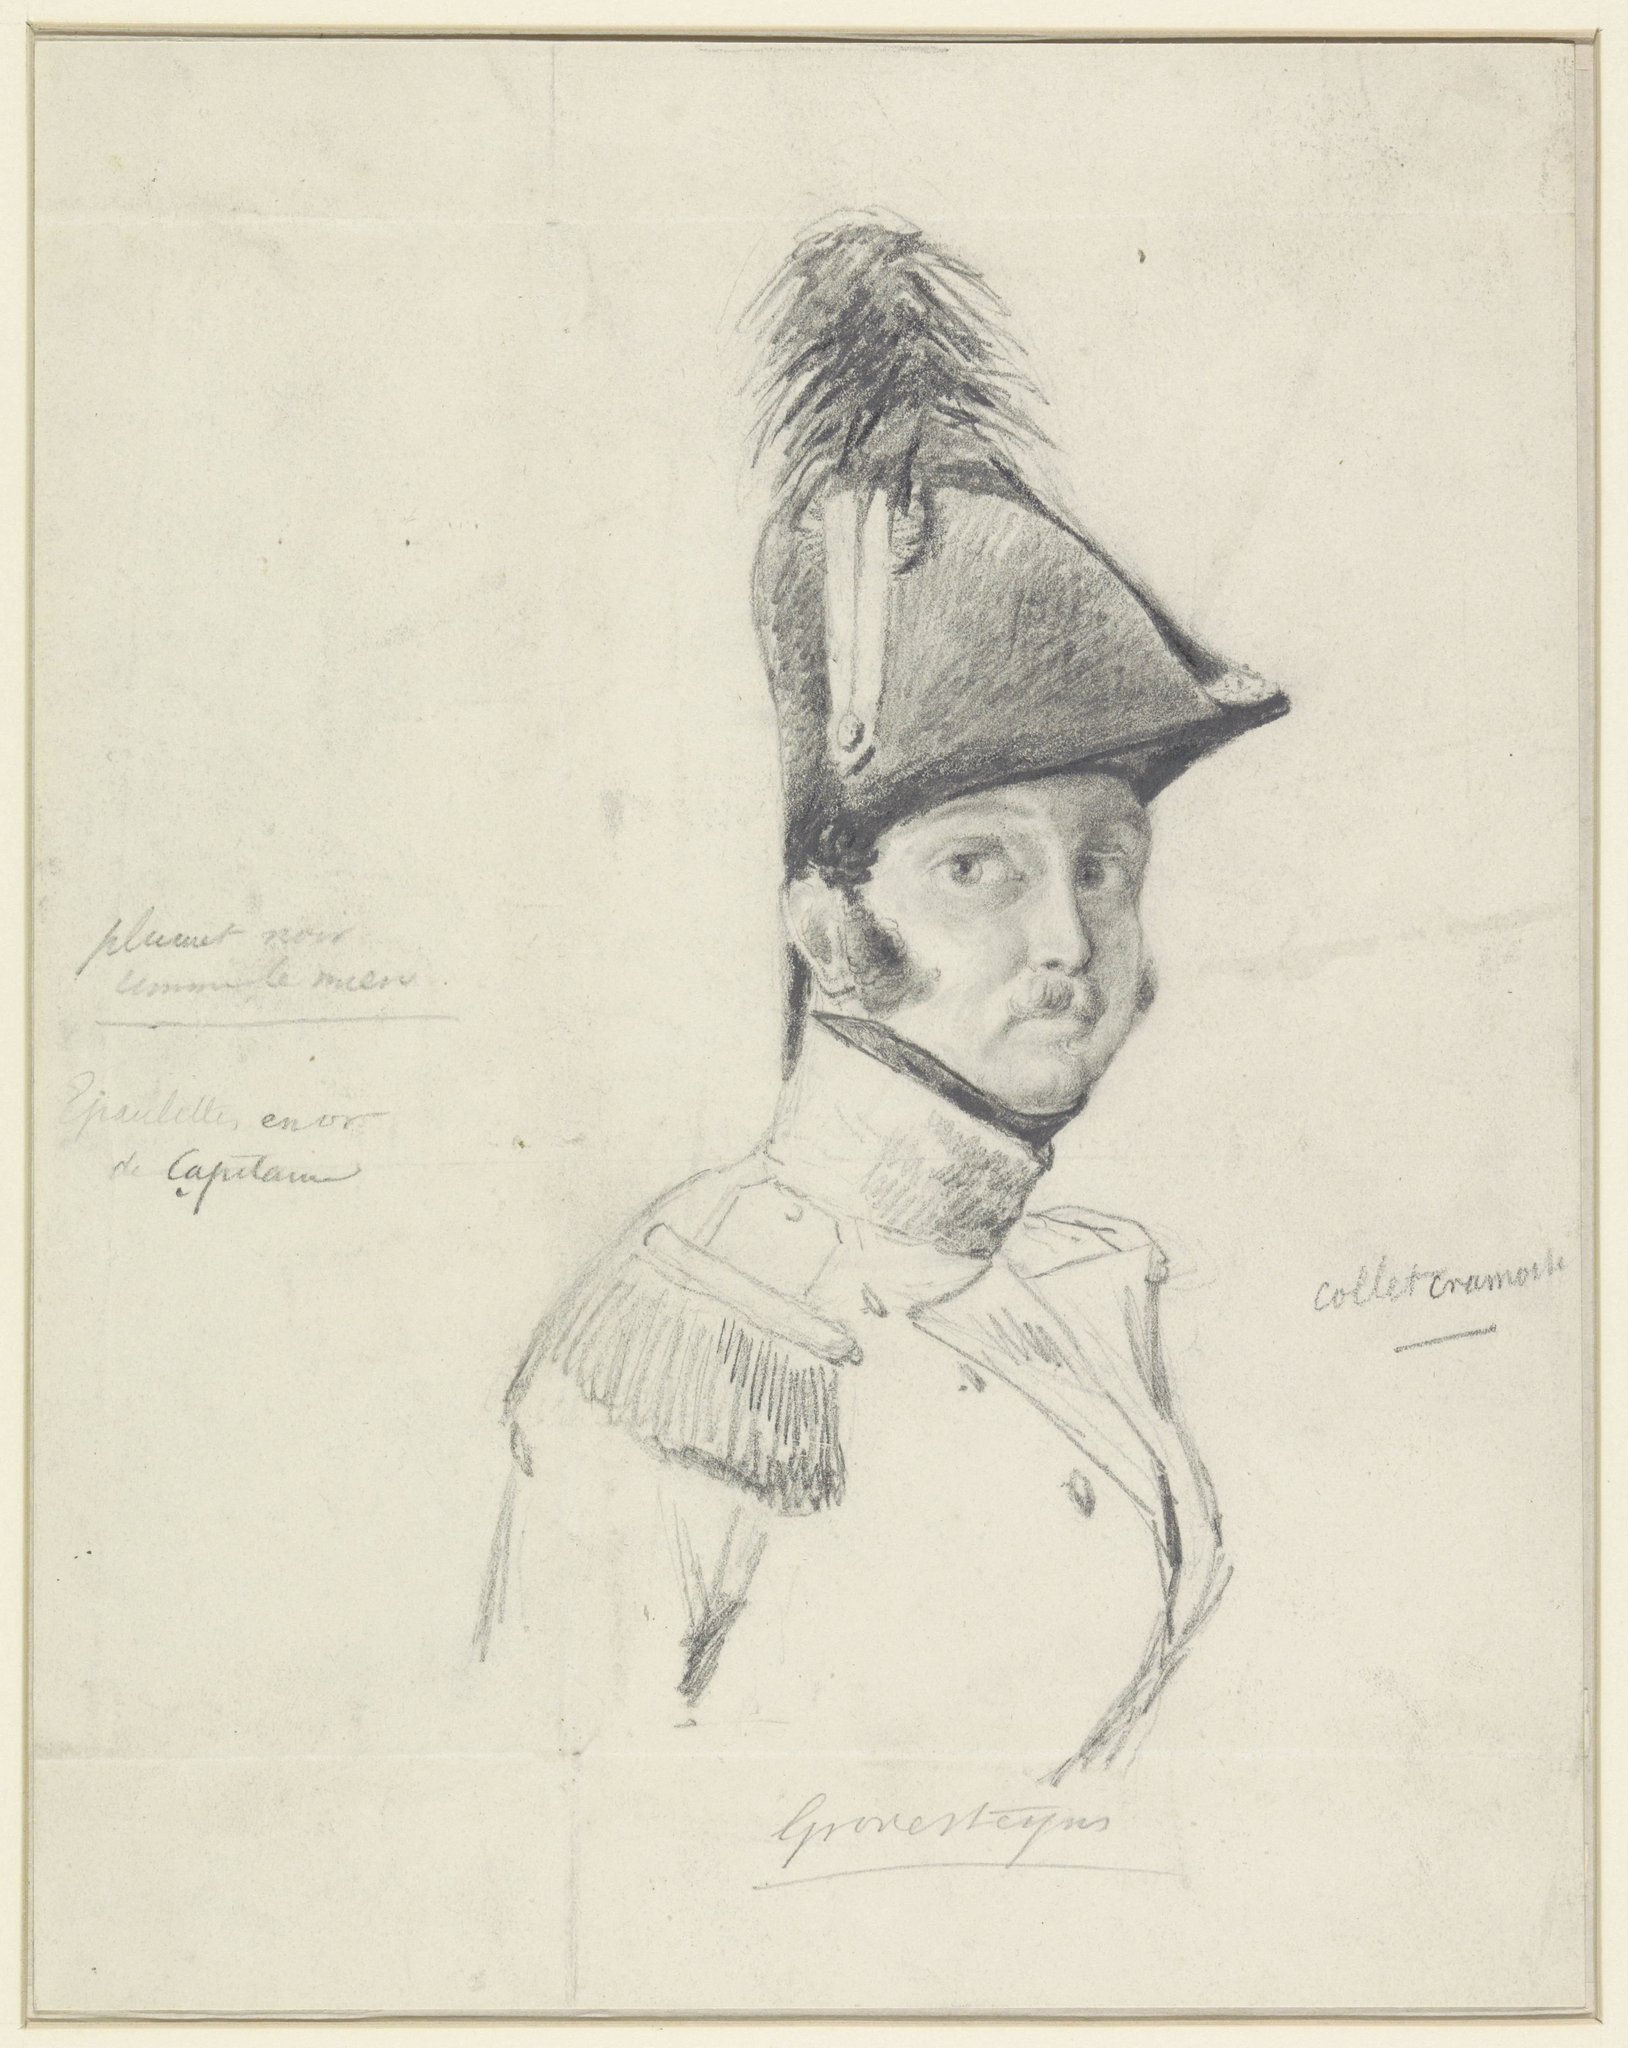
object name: drawing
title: Portret van Baron Sirkma van Grovestins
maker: jacob joseph eeckhout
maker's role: draughtsman, print maker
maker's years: 1793-1861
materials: paper, pencil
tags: historical persons, officer